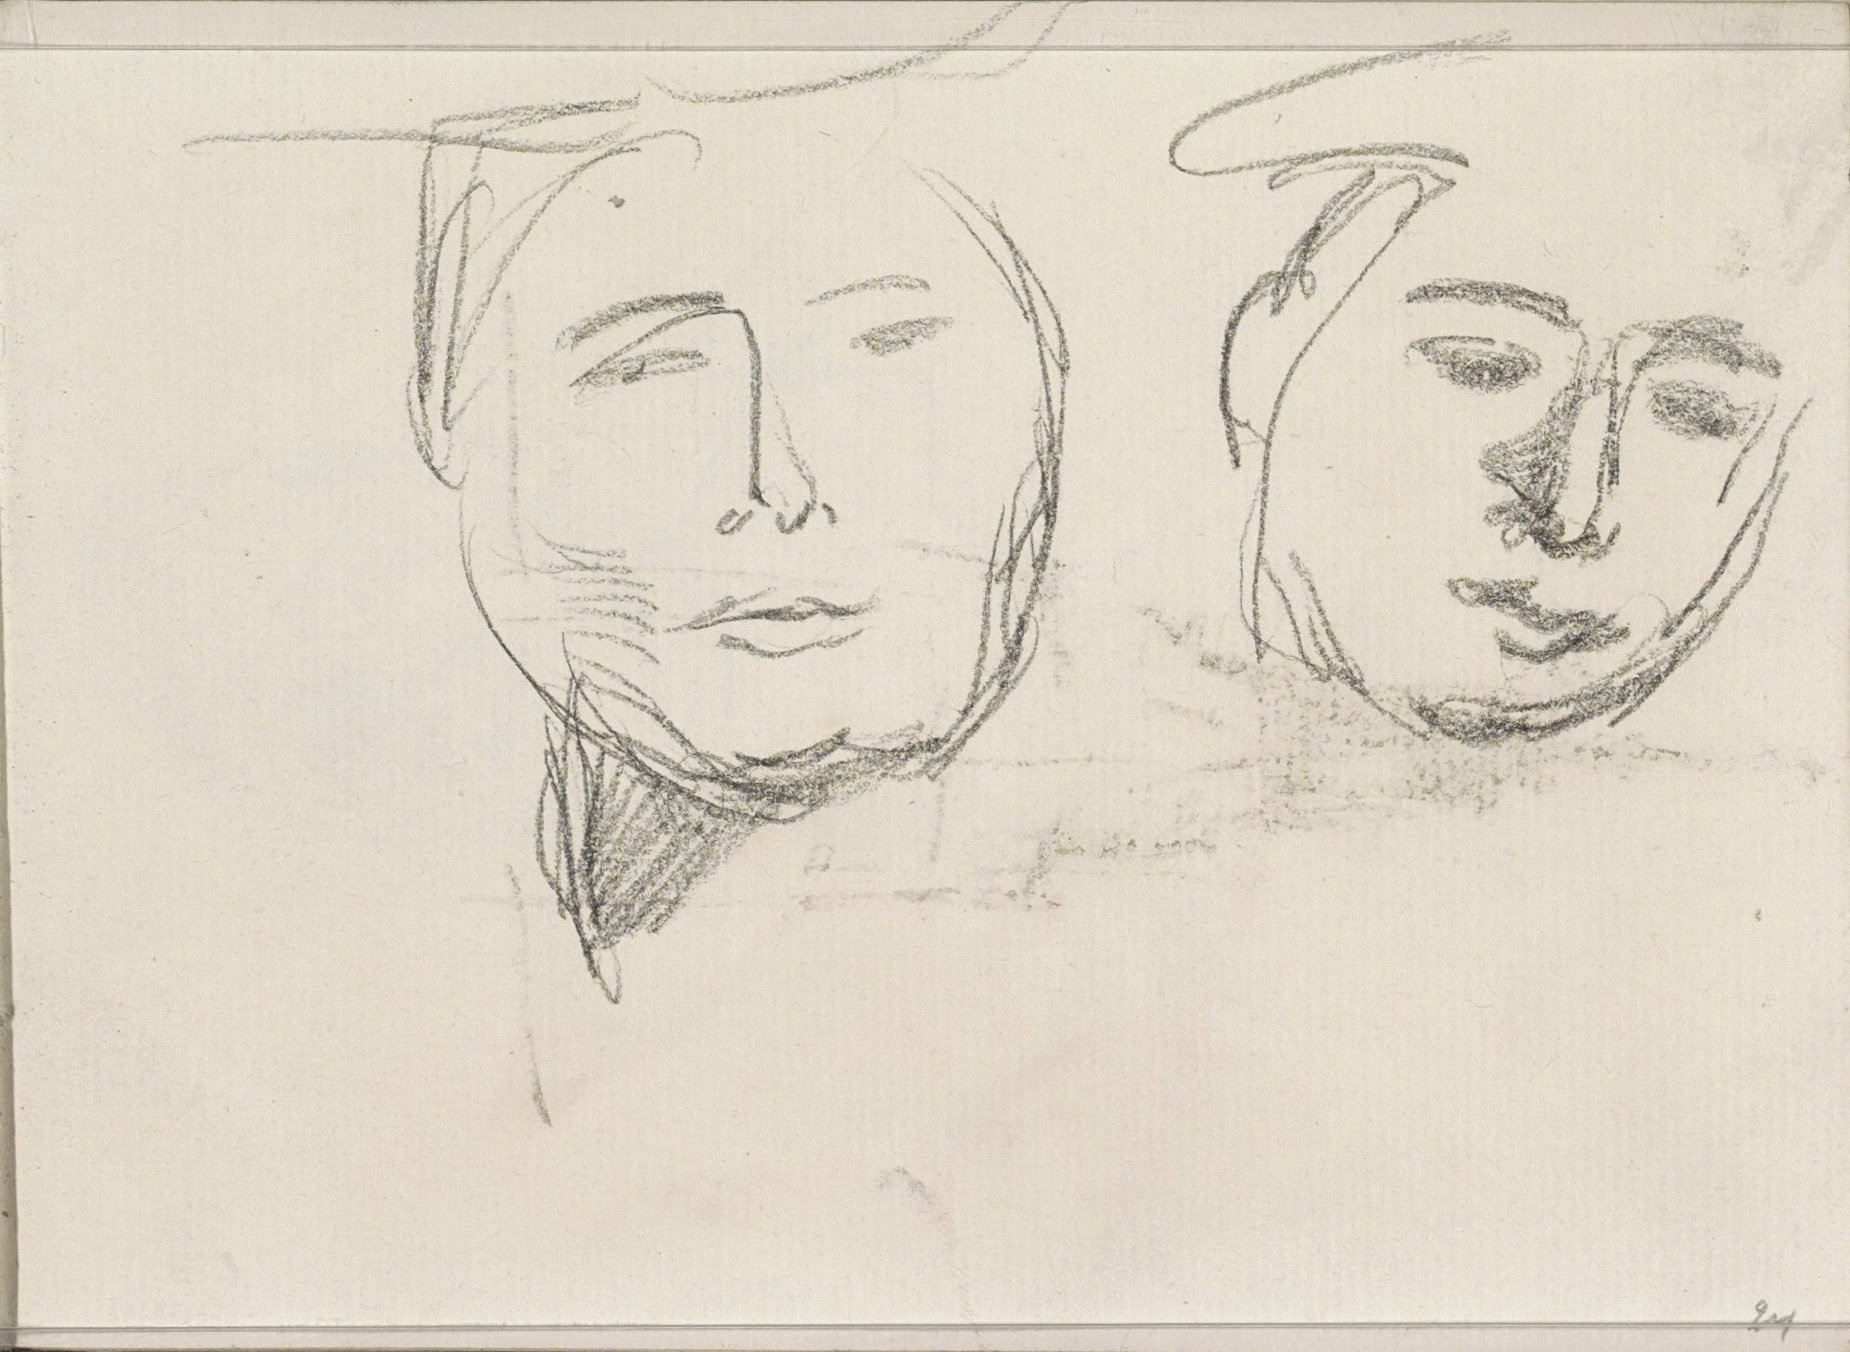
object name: sketchbook leaf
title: Twee vrouwenhoofden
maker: isaac israels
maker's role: draughtsman, painter, print maker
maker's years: 1865-1934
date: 1875-1934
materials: chalk, paper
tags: head (human) - aa - female human figure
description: Blad 24 recto uit schetsboek LVI met 26 bladen.